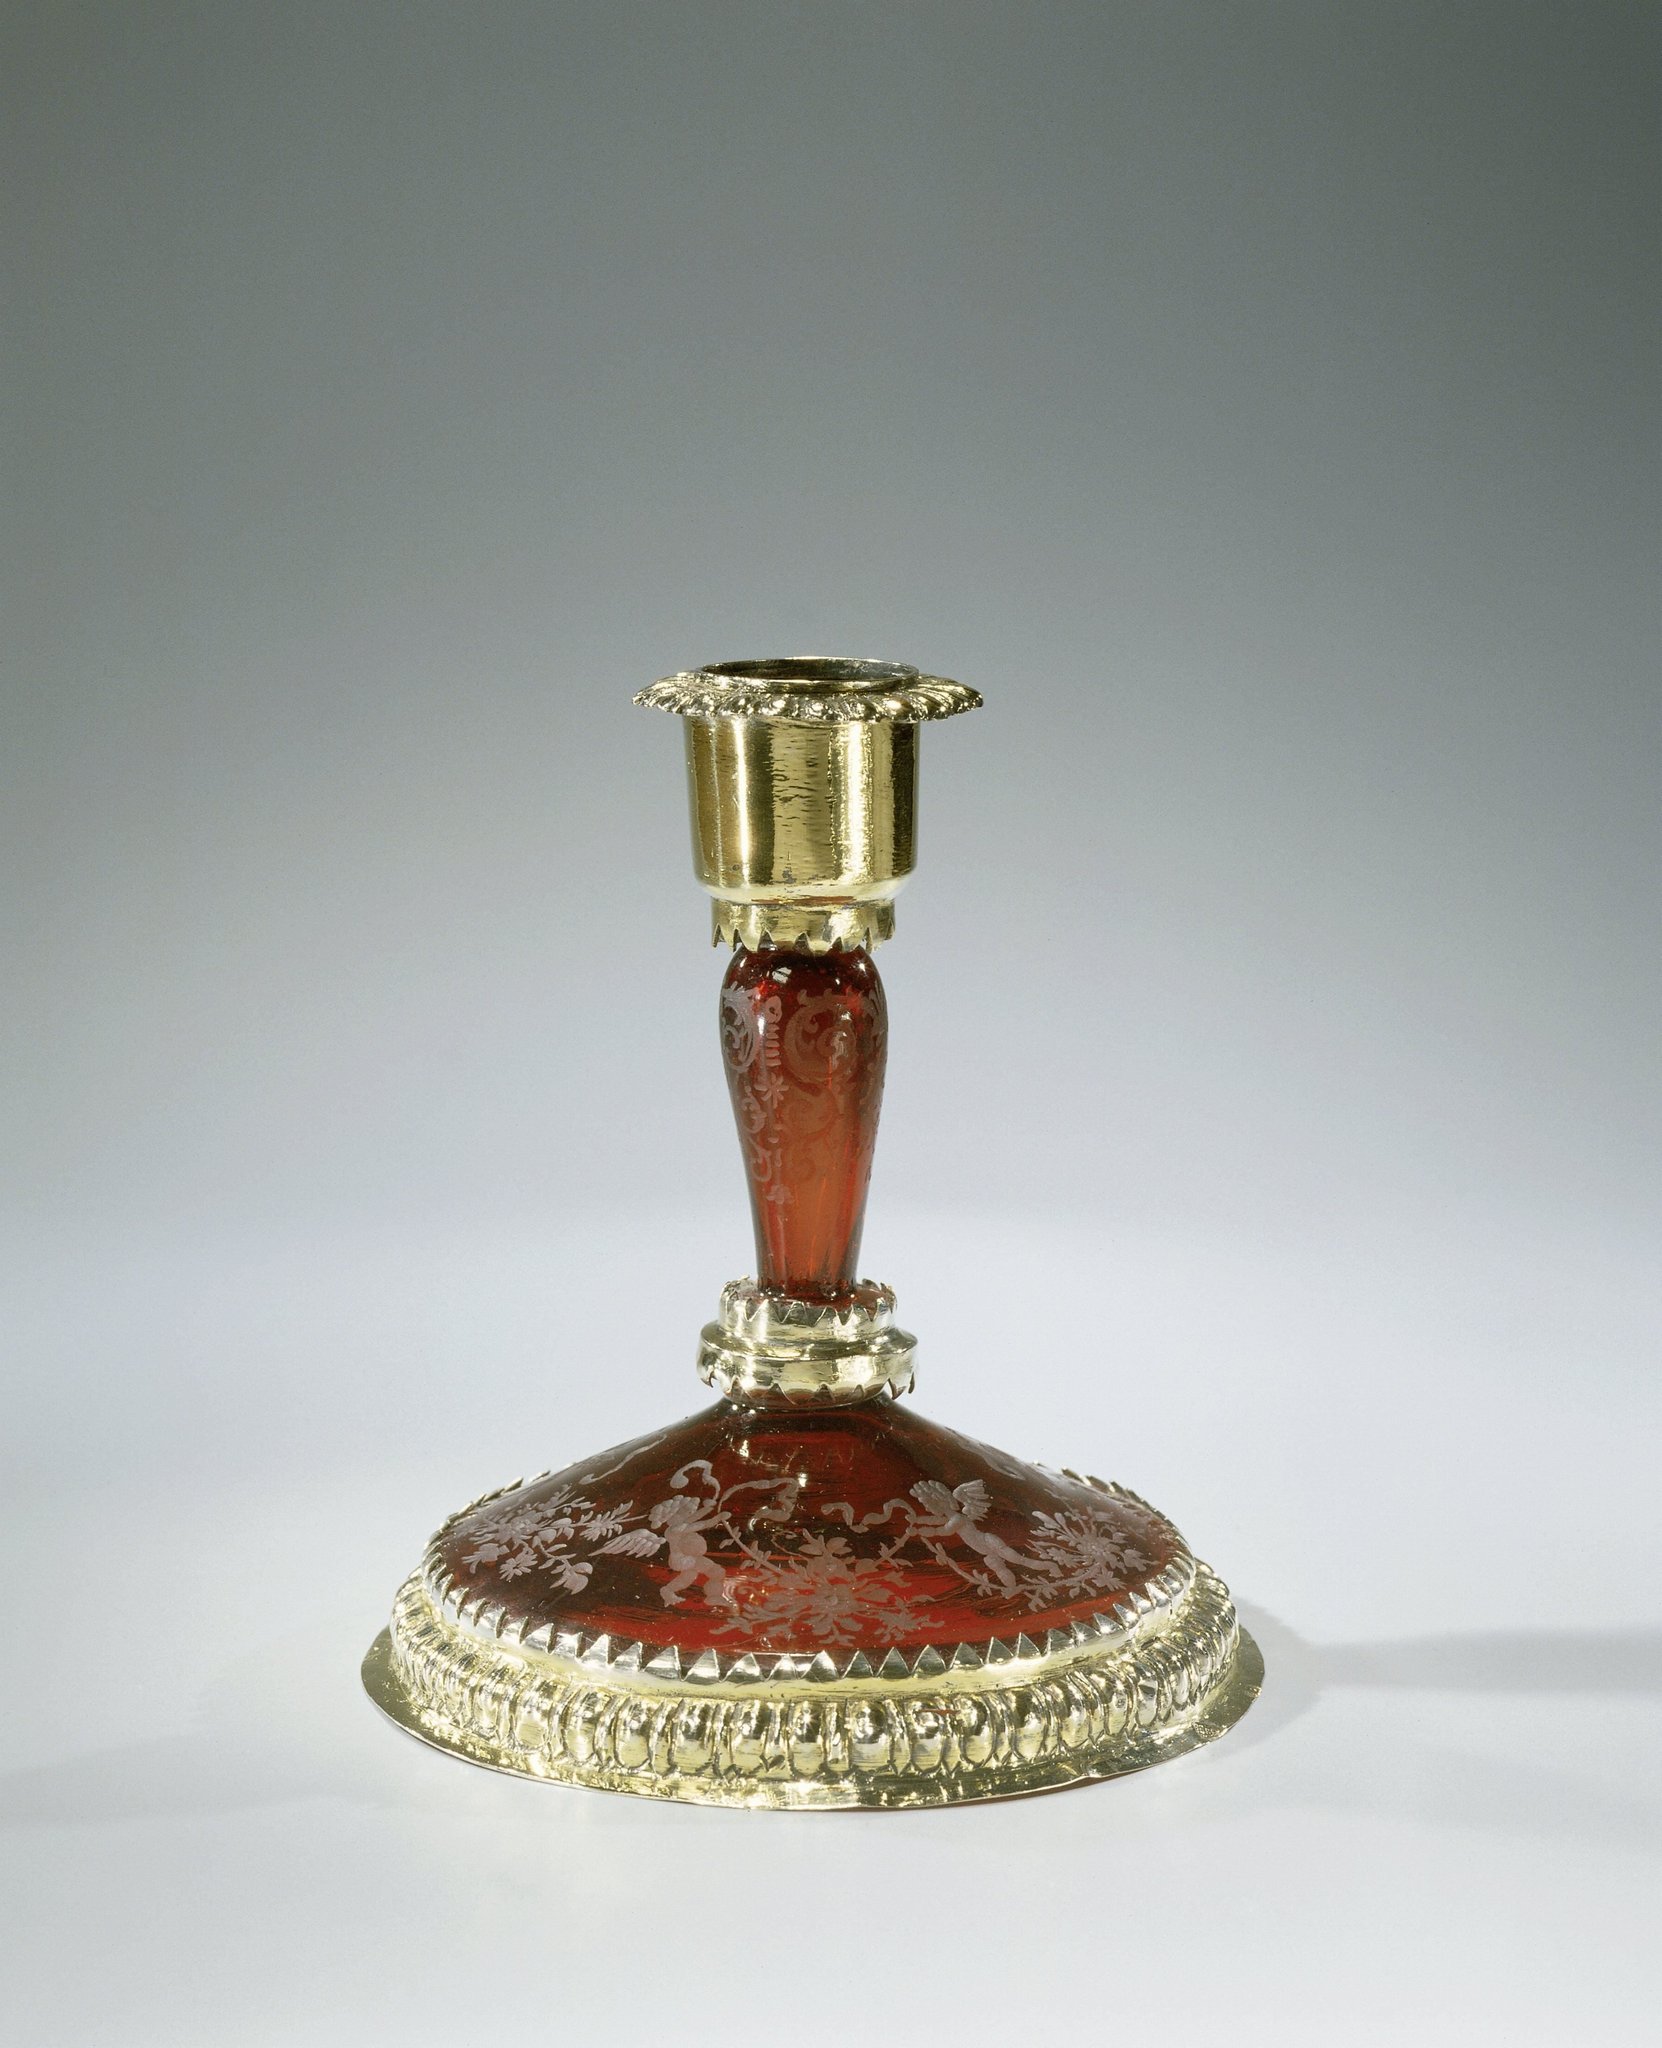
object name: candlestick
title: Kandelaar van robijnglas met verguld zilveren montuur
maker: Anonymous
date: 1700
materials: glass, silver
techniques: gilding, glassblowing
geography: augsburg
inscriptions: maker's mark, town mark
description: Candlestick. Ruby glass. Wheel engraving. Mounted in silver-gilt. Germany, c. 1700. The mounts Augsburg, c. 1700.